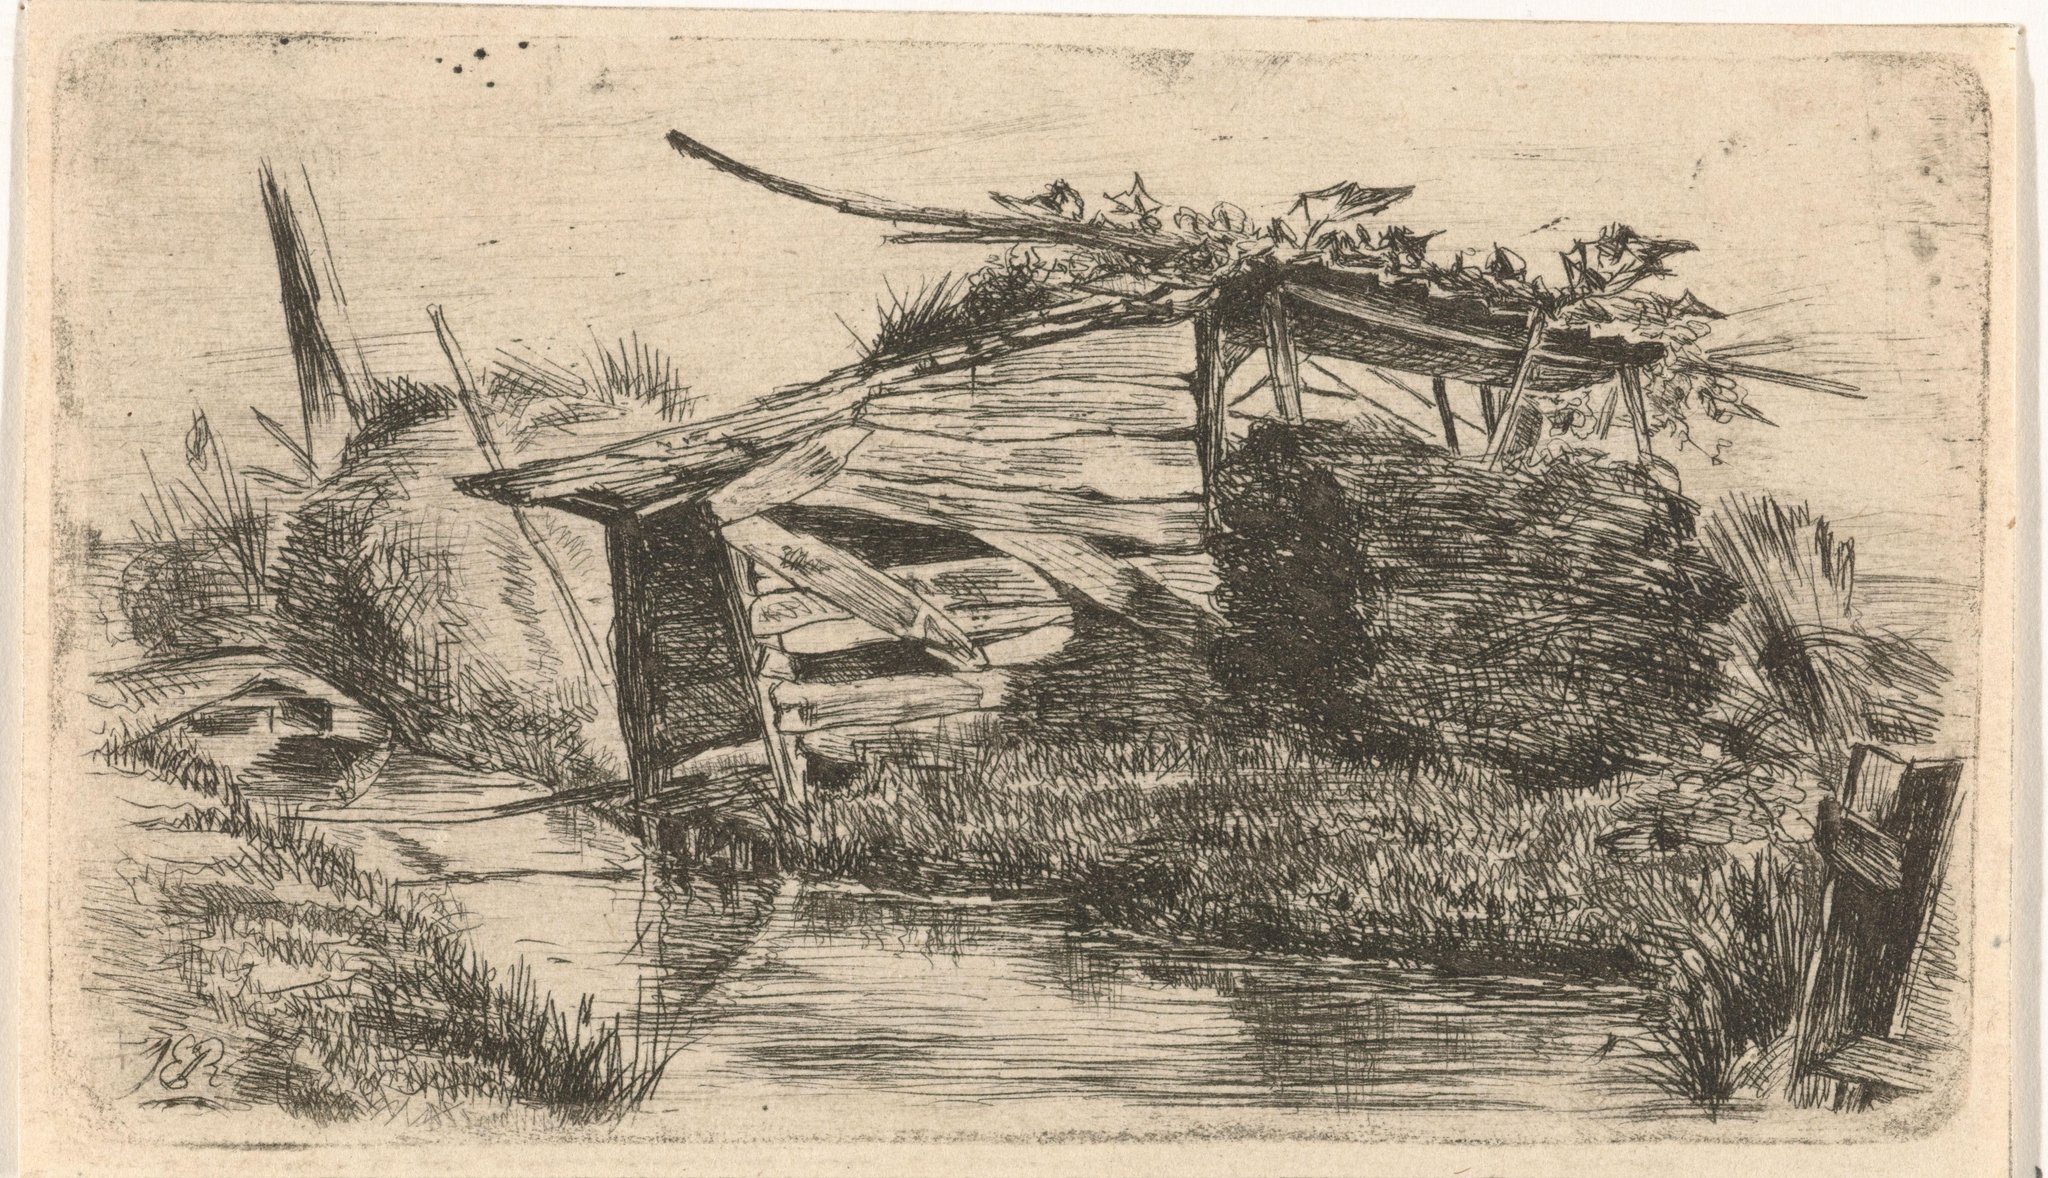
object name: print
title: Vervallen schuur aan een vaart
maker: johannes everhardus rijnboutt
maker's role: print maker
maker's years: 1839-1900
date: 1849-1882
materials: paper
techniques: etching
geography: netherlands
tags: canal, rowing-boat, canoe, etc., shed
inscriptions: collector's mark: Lugt 2228